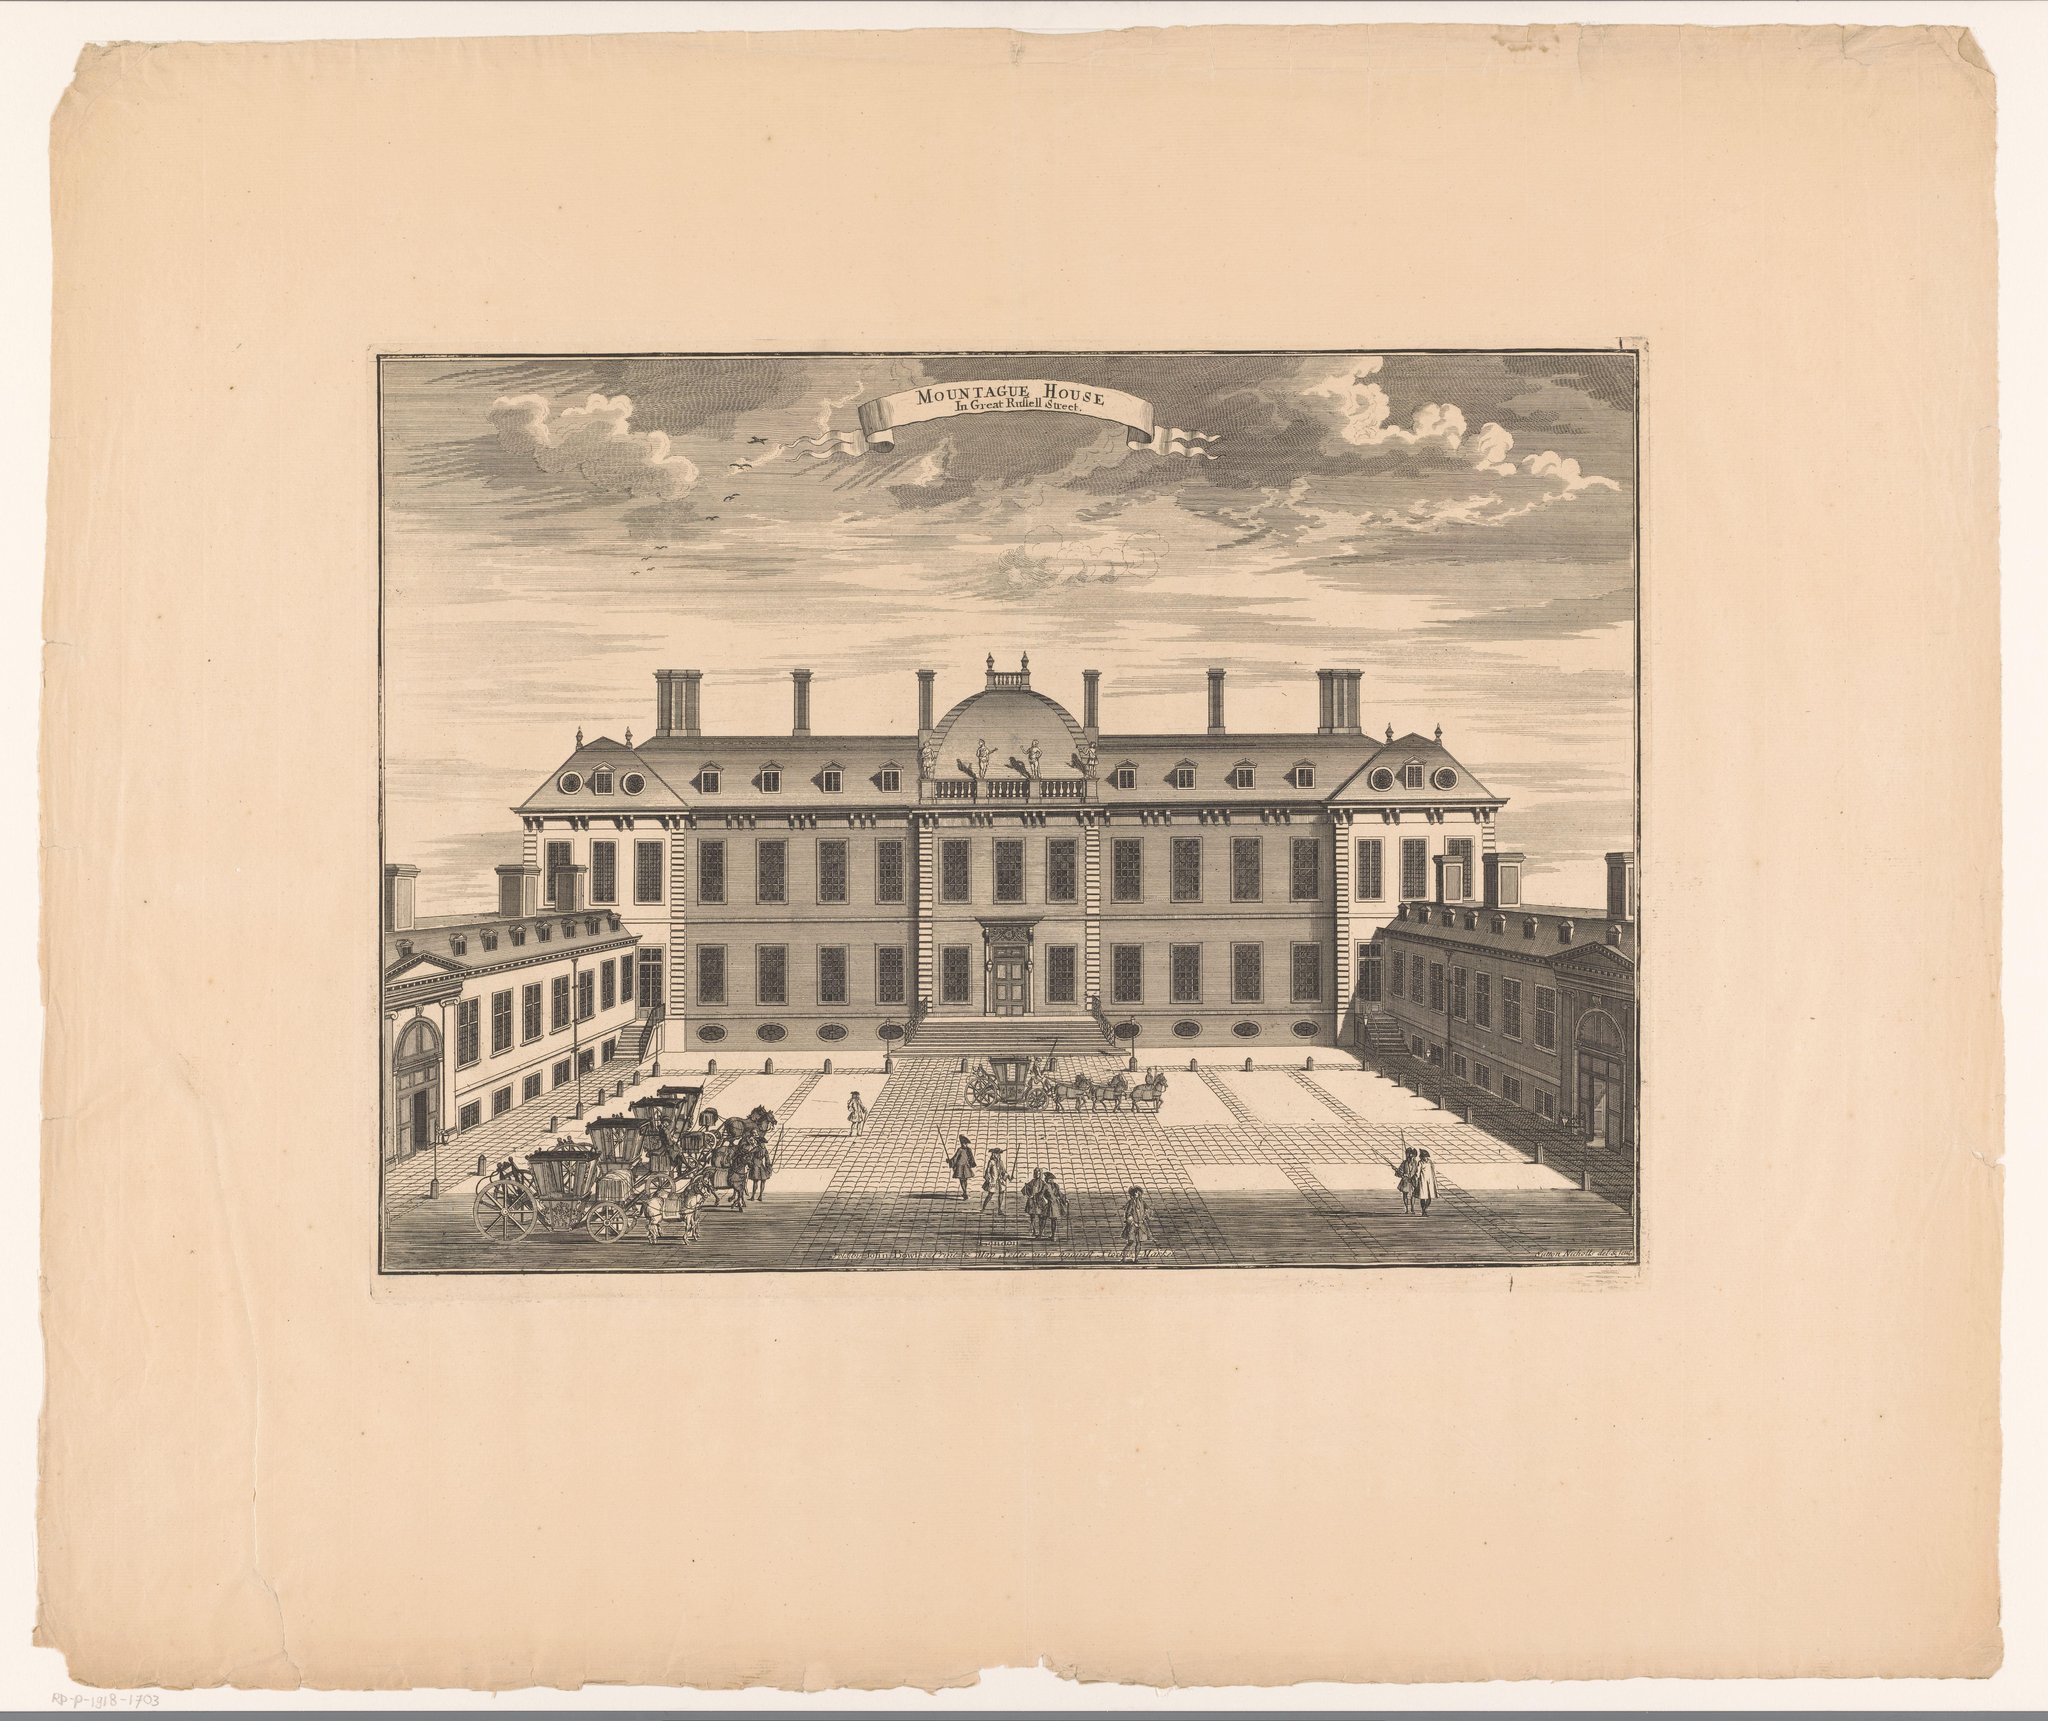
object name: print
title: London Described; or Perspective Views and Elevations of Noted Buildings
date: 1720-1731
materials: paper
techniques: engraving, etching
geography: london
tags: hôtel, i.e. small palace in city, london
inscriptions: collector's mark: Lugt 2233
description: Deze reeks werd voor het eerst compleet uitgegeven in 1731, al zijn de losse prenten al voor die tijd uitgebracht. De meeste prenten zijn vervaardigd door Sutton Nicholls. De serie werd aangeboden voor verkoop door John Bowles in zijn catalogus 1753, op pagina 76, nummer 16.